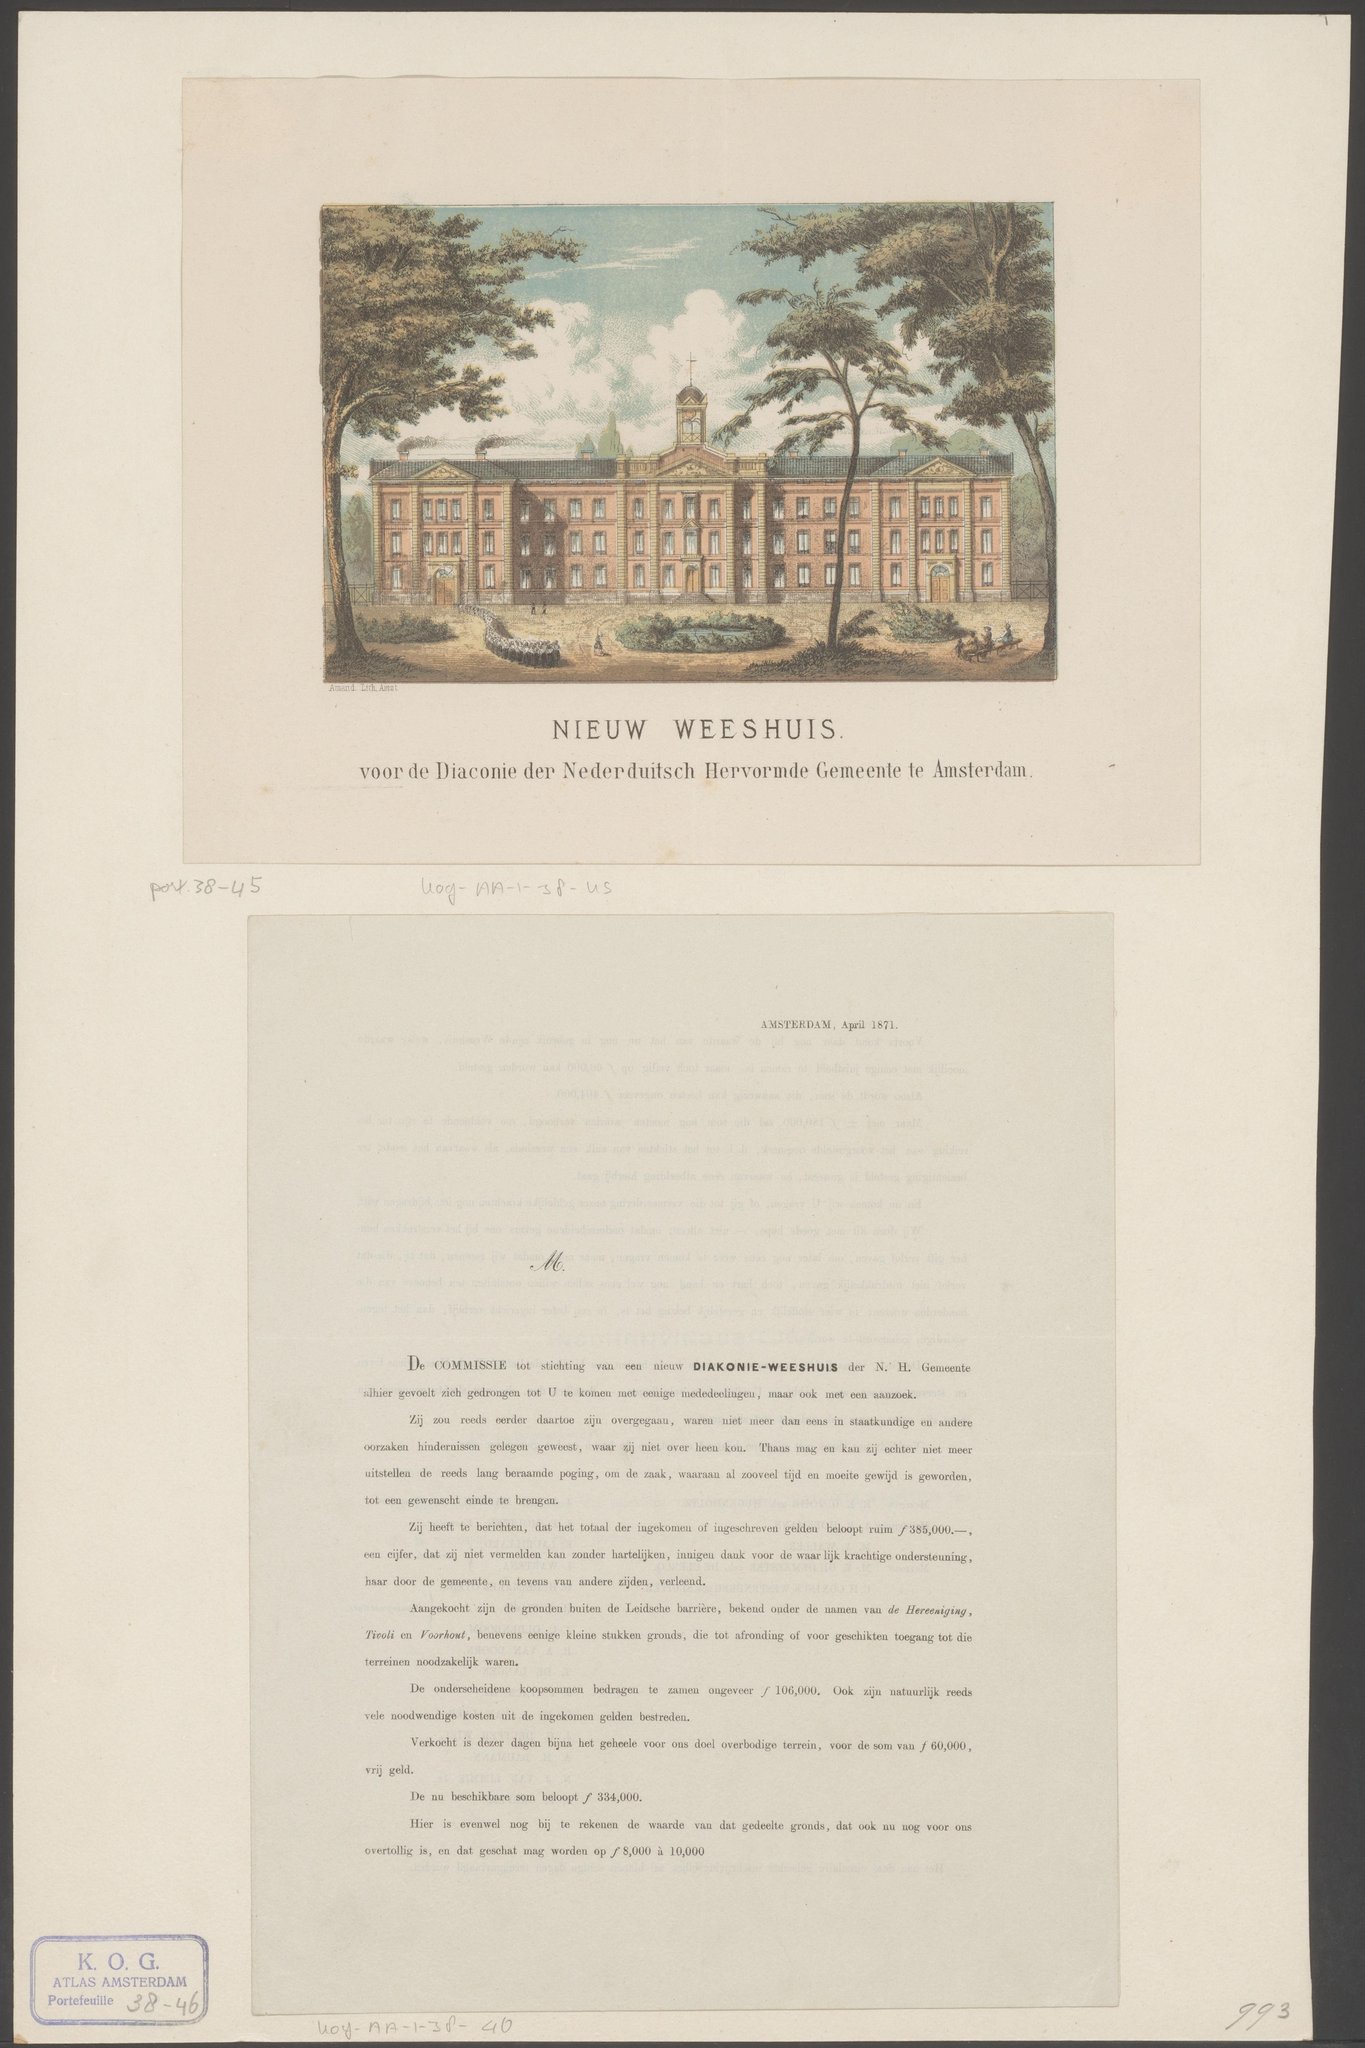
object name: text sheet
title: Oproep tot giften voor de bouw van het Diaconieweeshuis aan de Stadhouderskade te Amsterdam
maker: Anonymous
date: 1804-1871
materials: paper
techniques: letterpress printing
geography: amsterdam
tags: orphanage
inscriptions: collector's mark: Lugt 1641b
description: Onderwerpsrubriek binnen de Atlas Amsterdam: Armwezen en liefdadige instellingen: II. Kerkelijke inrichtingen: Diaconie Weeshuis der Ned. Herv. Gem. Stadhouderskade.